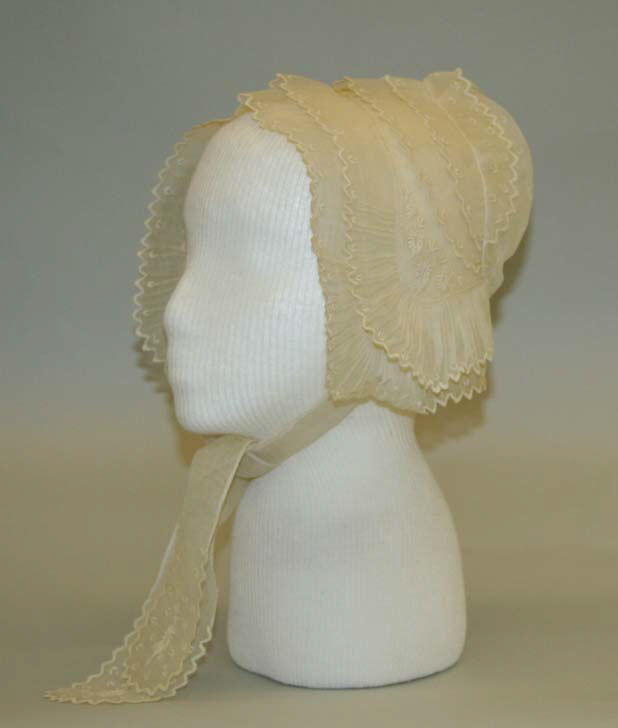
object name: morning cap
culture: french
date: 1834-1866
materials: cotton